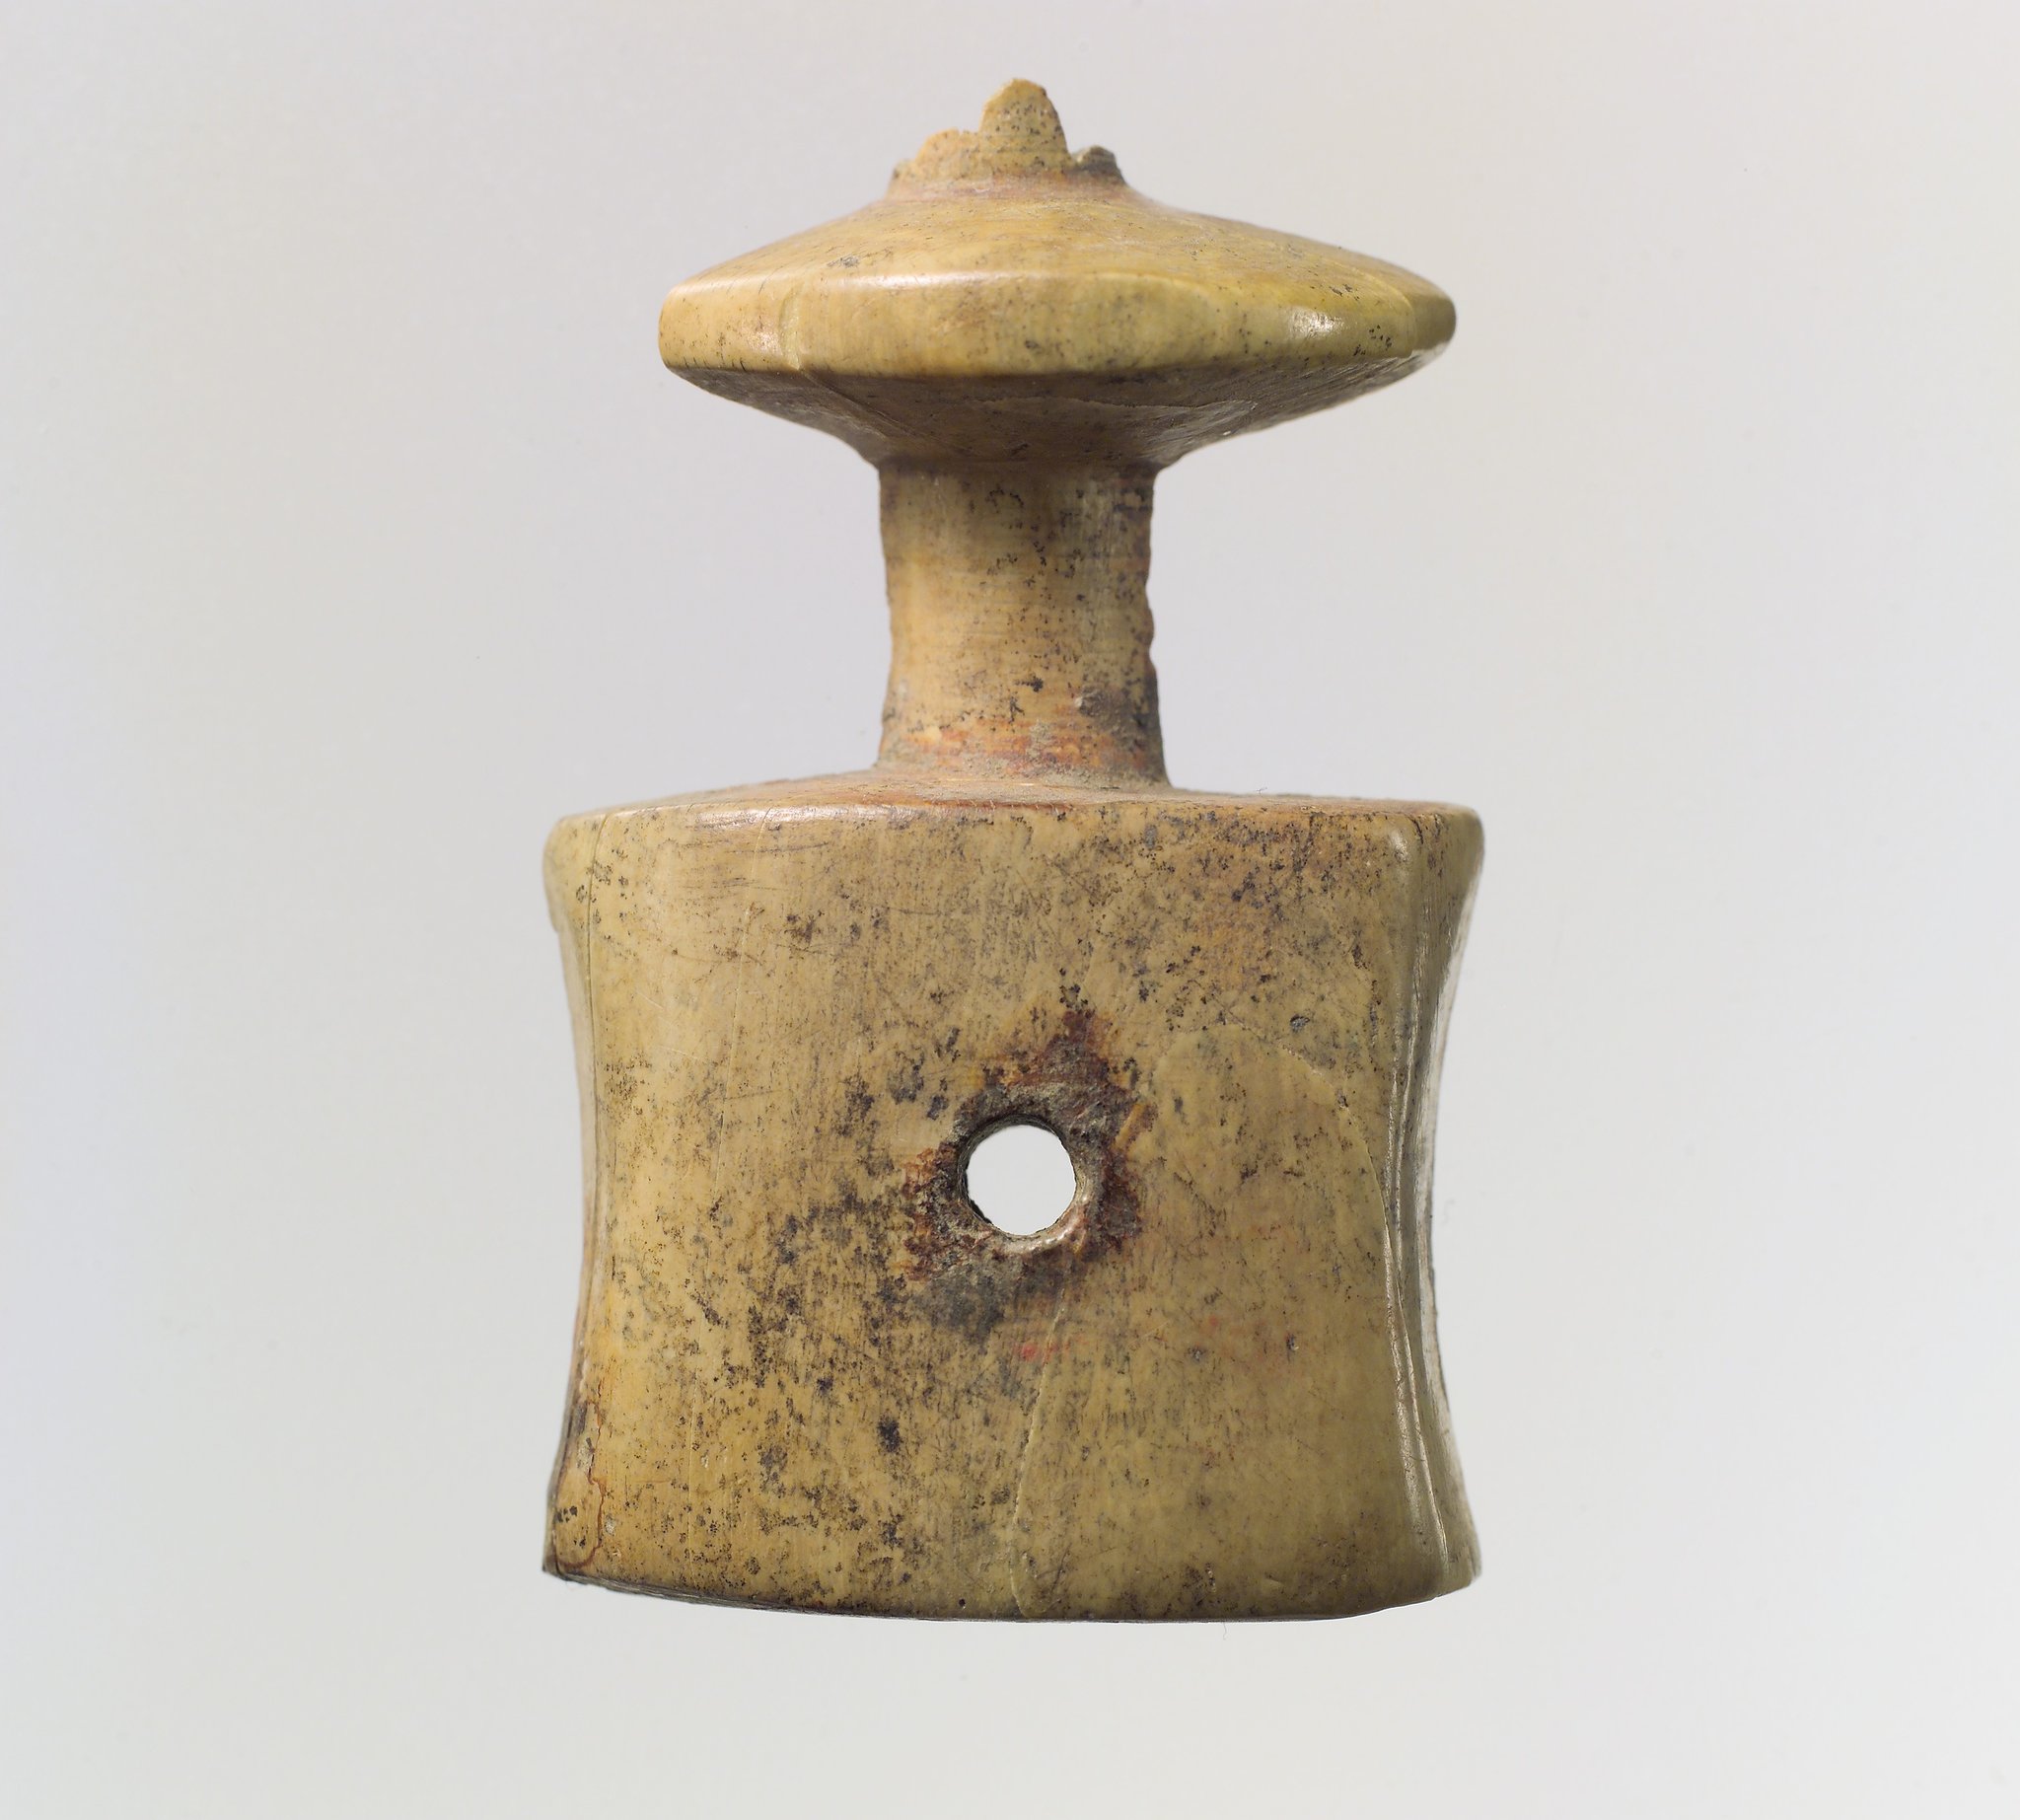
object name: dagger hilt inlay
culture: iranian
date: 900-801 BCE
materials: ivory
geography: iran